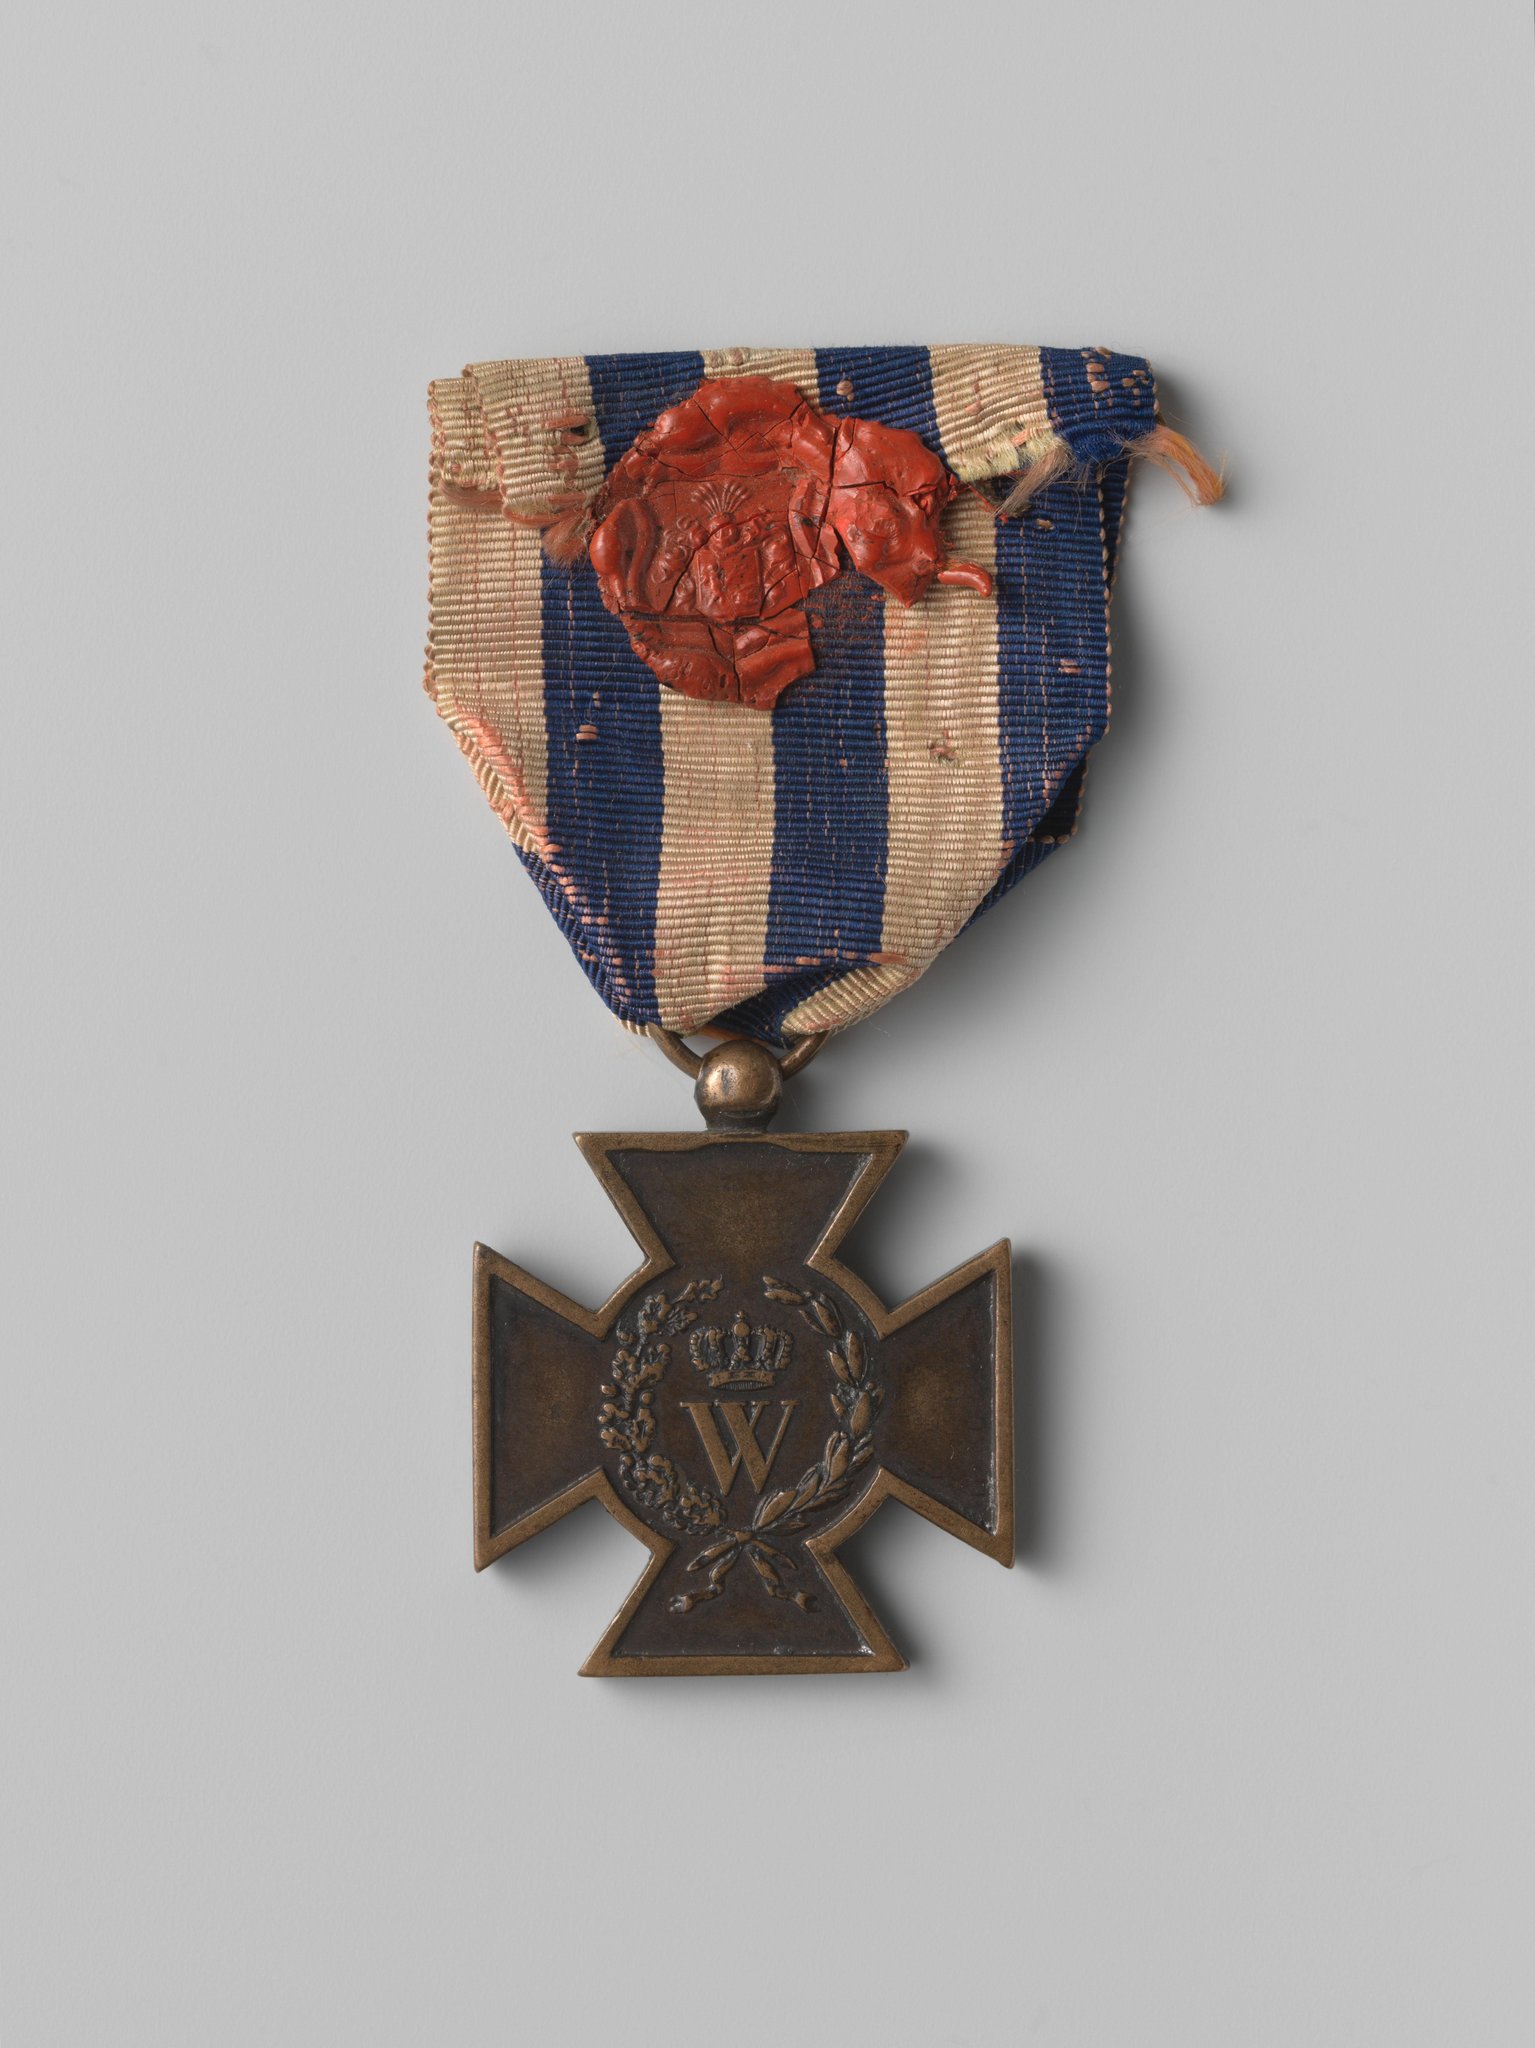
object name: onderscheidingsteken, onderscheiding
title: Metalen kruis, gedragen door de generaal baron Chassé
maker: Anonymous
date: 1830-1831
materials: lacquer, metal, silk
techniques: sawing, soldering, striking, weave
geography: netherlands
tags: david hendrik baron chassé, netherlands, belgium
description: Een geel metalen vierbenig kruis, met wijd uitlopende benen. Midden: Nederlandse kroon omgeven door (links) eikentak, (rechts) lauwertak, beiden bijeen gehouden met een lint. Achterzijde, in benen: trouw aan koning en vaderland. In midden dito kruis en jaartallen 1830-1831. Boven kruis: geel metalen knop, waardoorheen dito ring, kruis hangt aan verticaal gestreept blauw - wit - blauw - wit -blauw - wit lint. Bovenzijde lint omgeslagen en met rode lak verzegeld. Hierin wapen: dwarsbalk van rechtsboven naar linksonder, wapen getooid met helm en face (bekroond met pauweveren?). Wapen omgeven met dekkleed. Speld tussen lint. Model kruis "metalen kruis" 1830-1831 (geslagen van brons, afkomstig van veroverd Belgisch geschut). Gedragen door de generaal baron Chassé, verdediger van de citadel van Antwerpen (1832). Dit kruis zat met het kruis van de "militaire Willemsorde" met een speld bevestigd aan de oranje sjerp (nr.4) van de generaal. Restanten van een lakzegel achter op het lint. Het kruis ligt in een doos met het opschrift: Roosdorp 4 metalen kruis van baron Chassé.